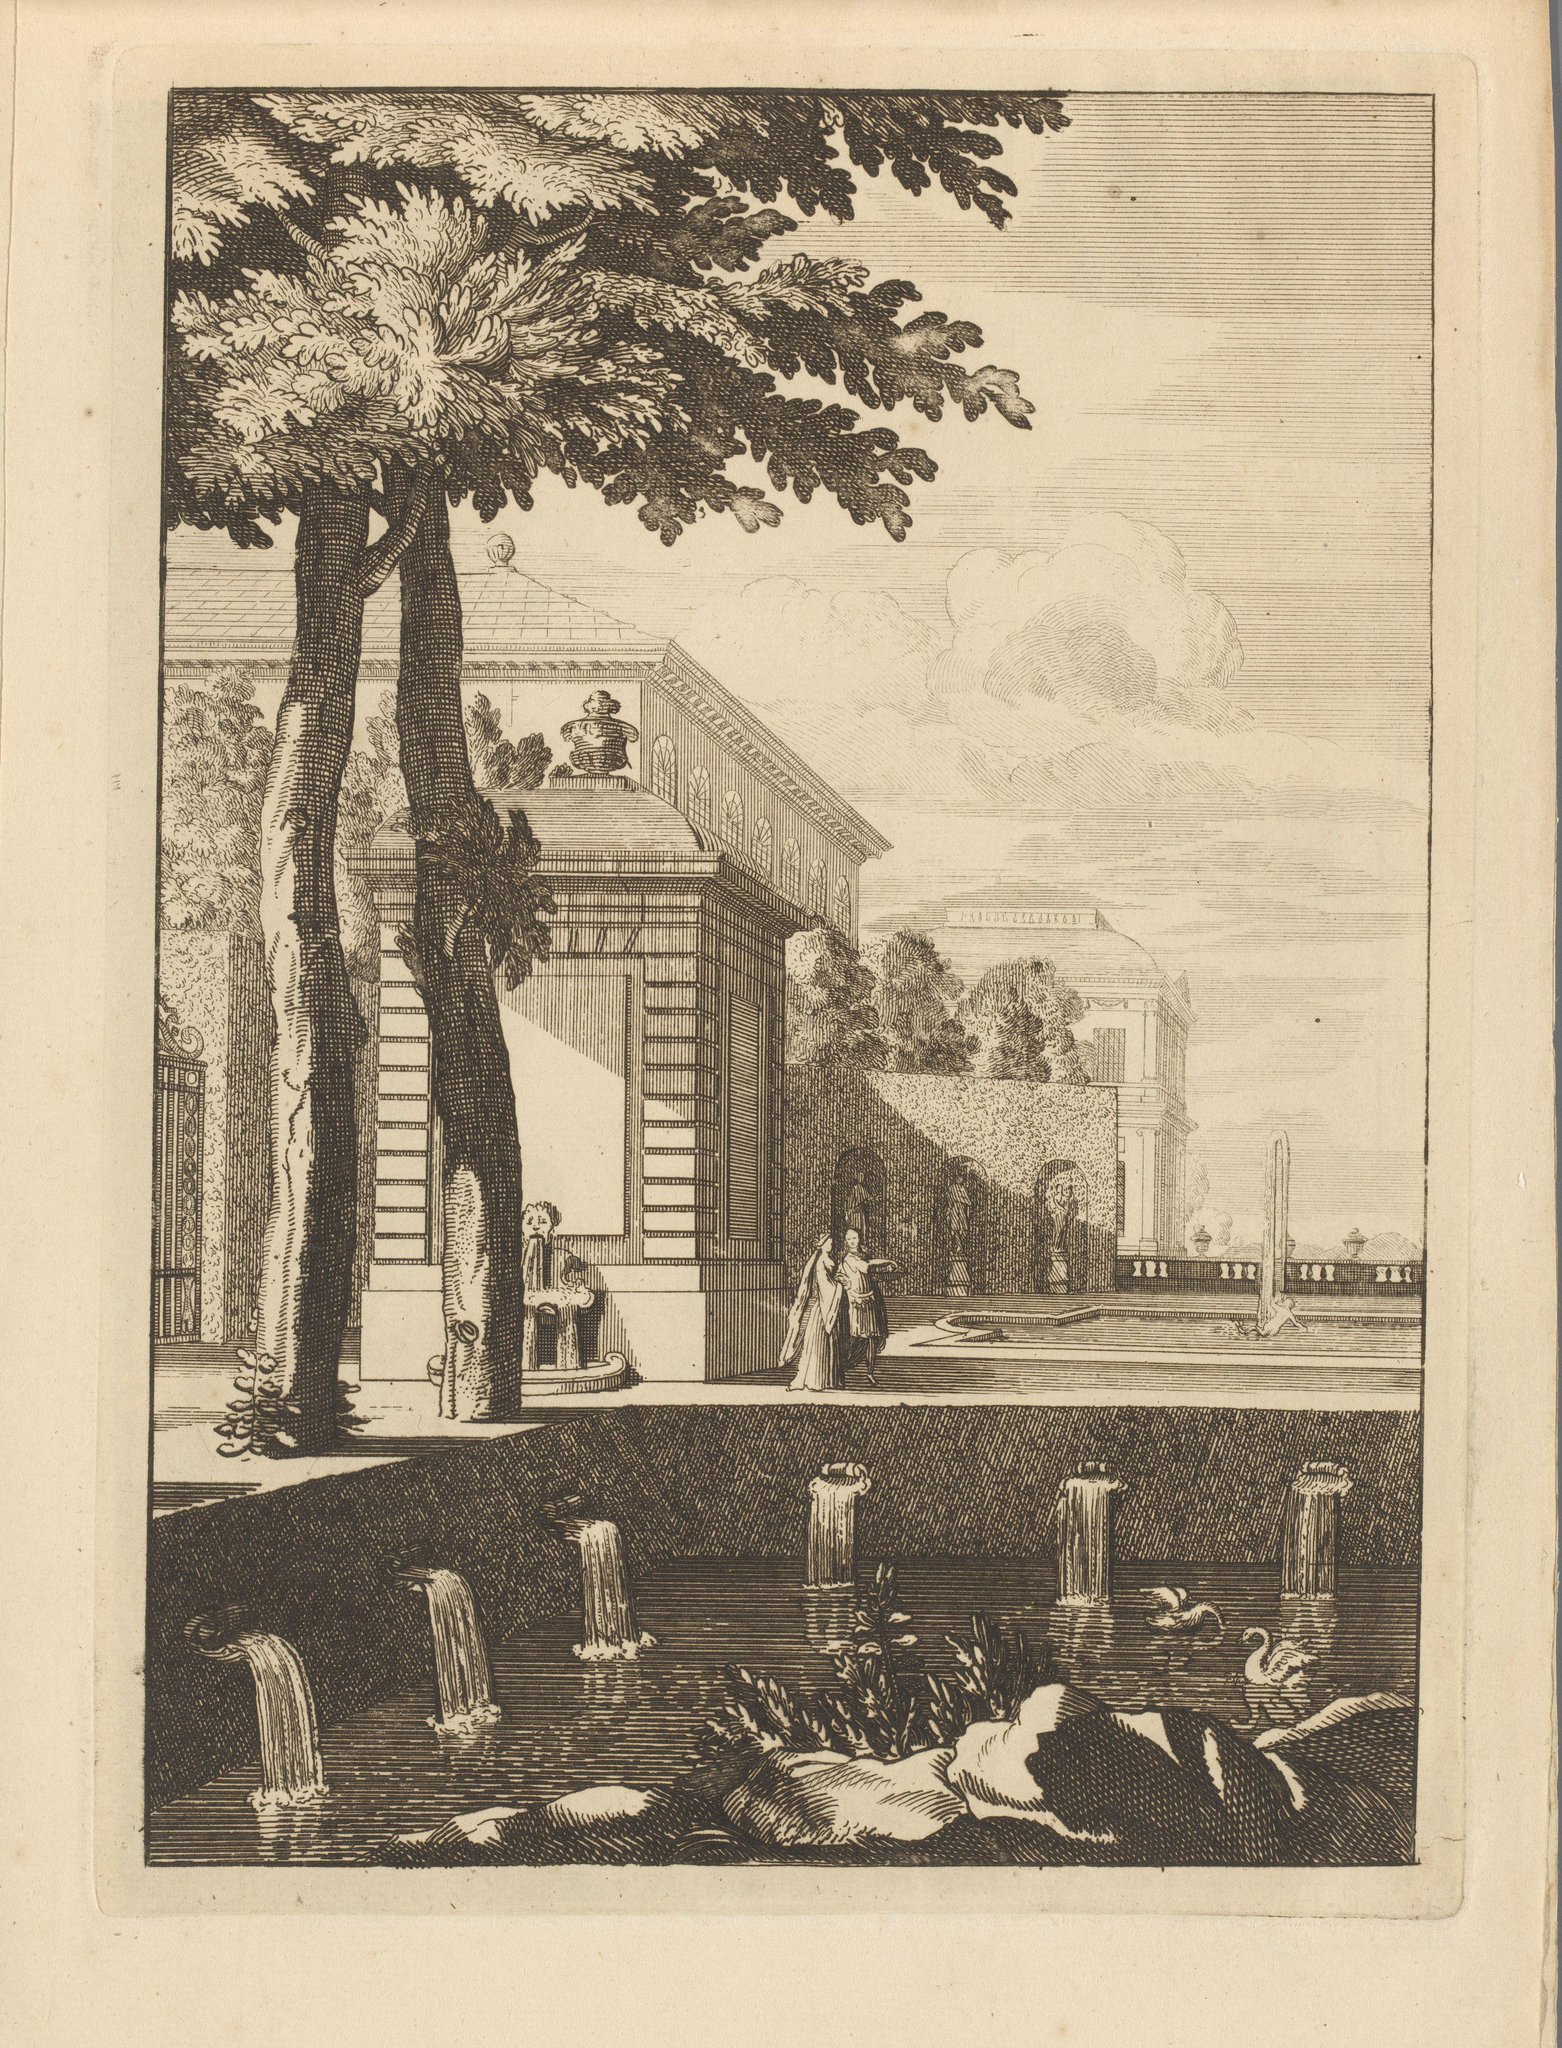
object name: ornament print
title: Troisieme Liure de Perspectives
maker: Anonymous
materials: paper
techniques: etching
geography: netherlands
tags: parts (of house or building), garden fountain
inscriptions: collector's mark: Lugt 2233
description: Naast de huizen is een tuinpaviljoen te zien en een terras met een bassin en een fontein. Op de voorgrond stroomt water in een bassin vanuit zes schelpen.